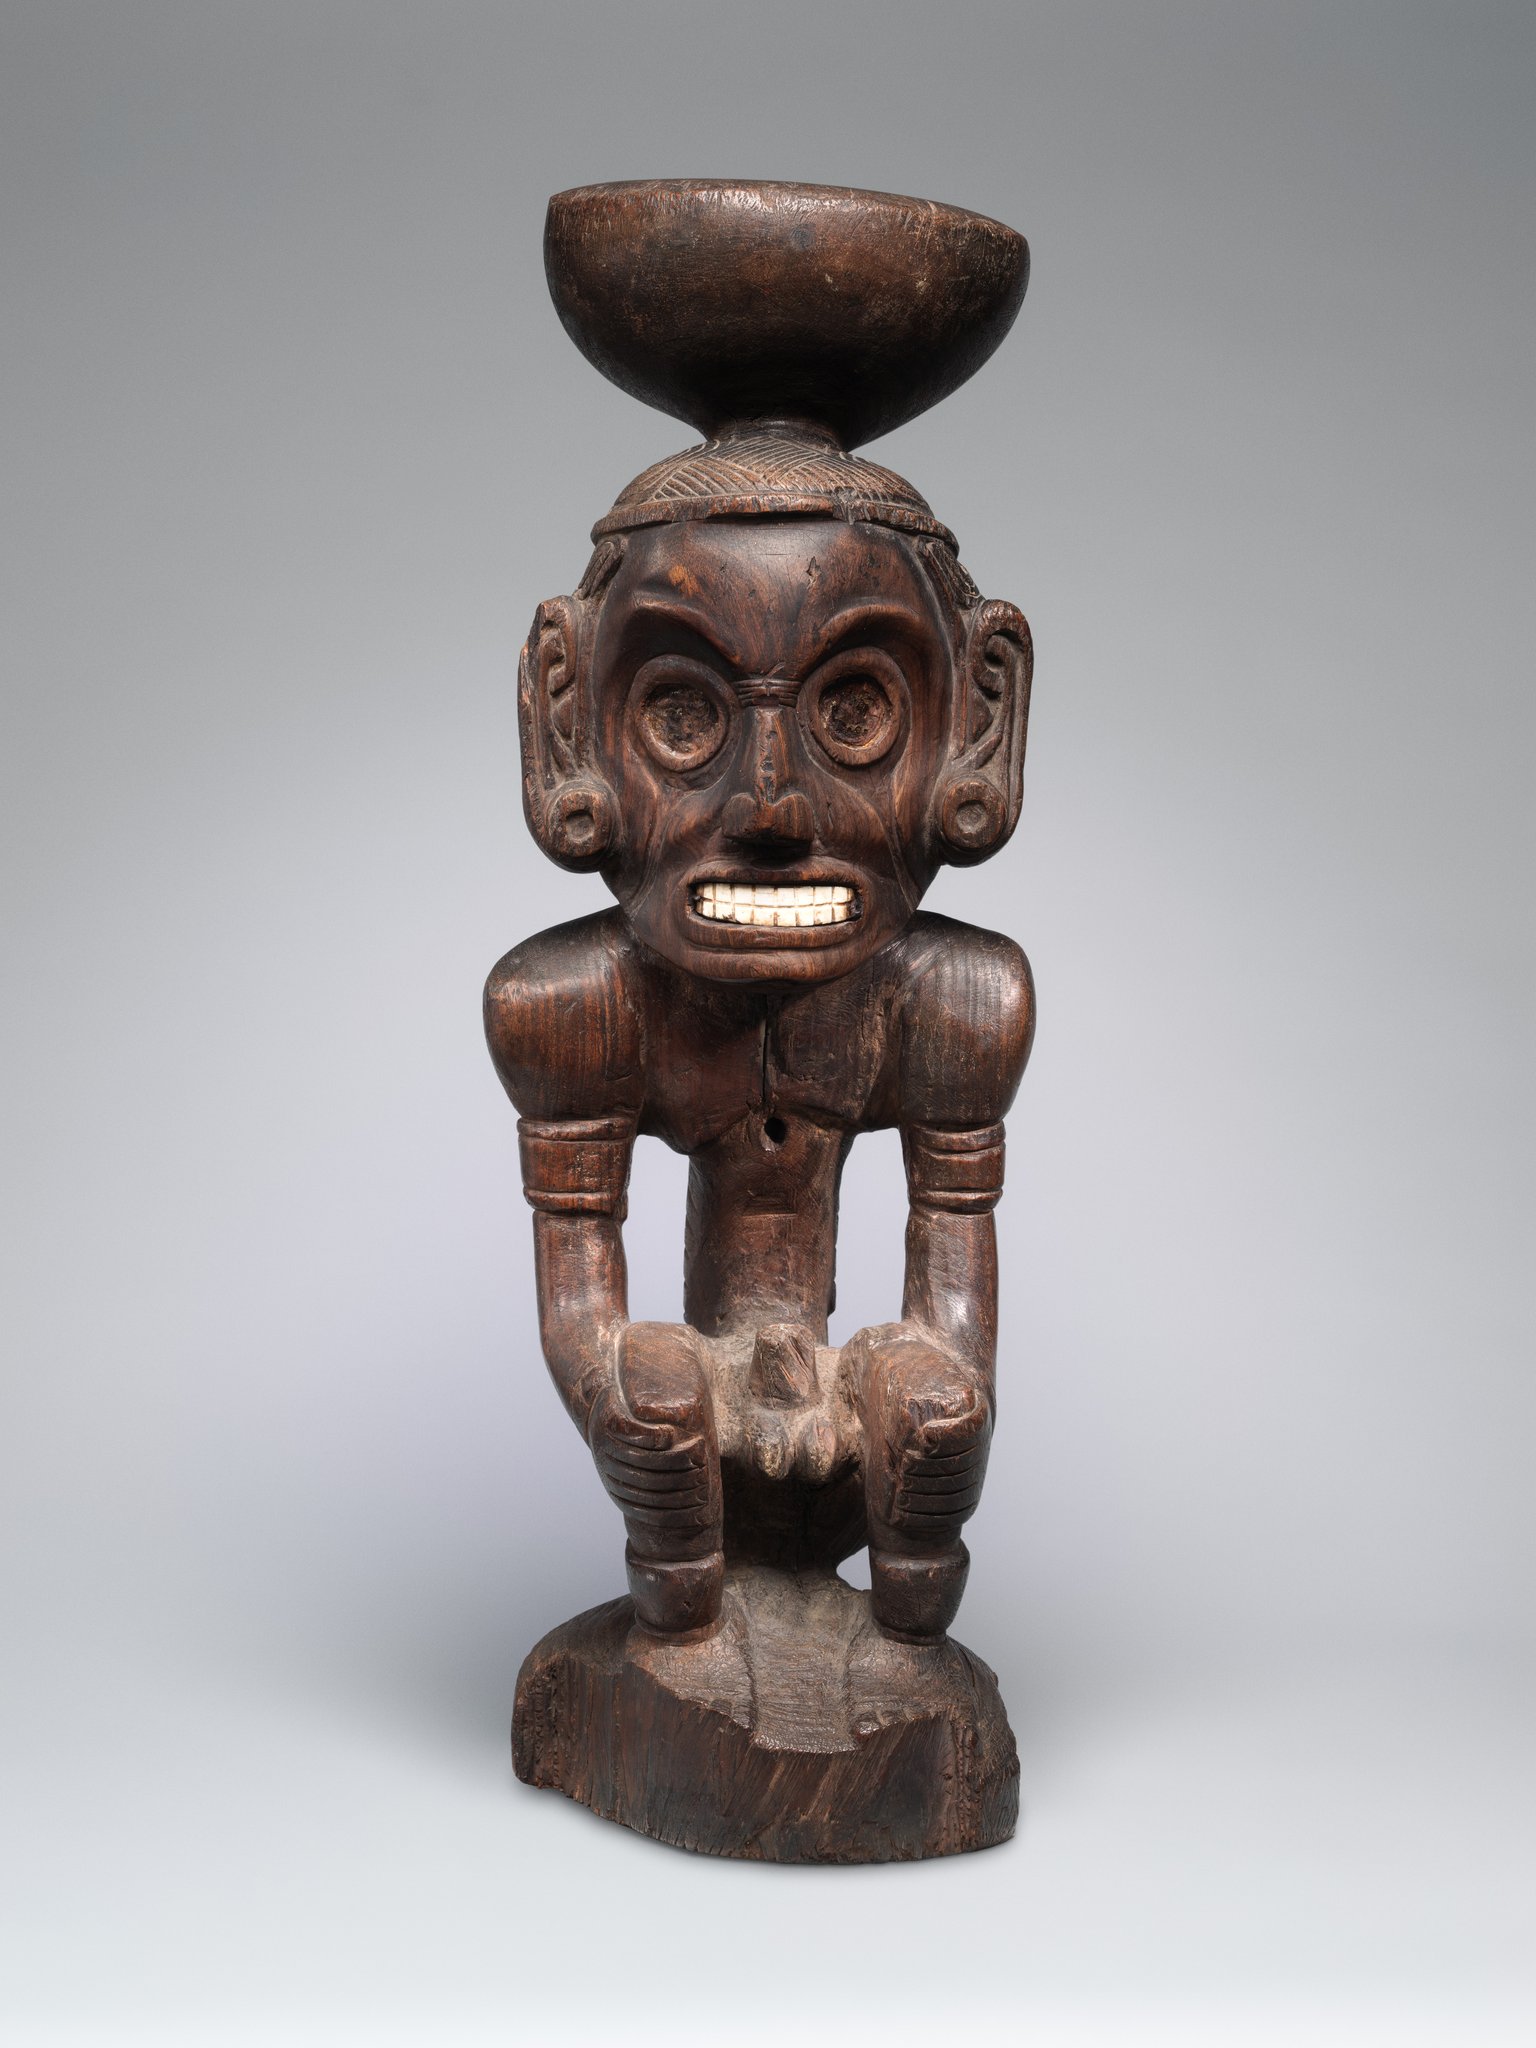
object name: figure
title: Zemí cohoba stand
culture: taíno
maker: taíno artist(s)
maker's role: artist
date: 1000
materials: shell, wood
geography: dominican republic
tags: men